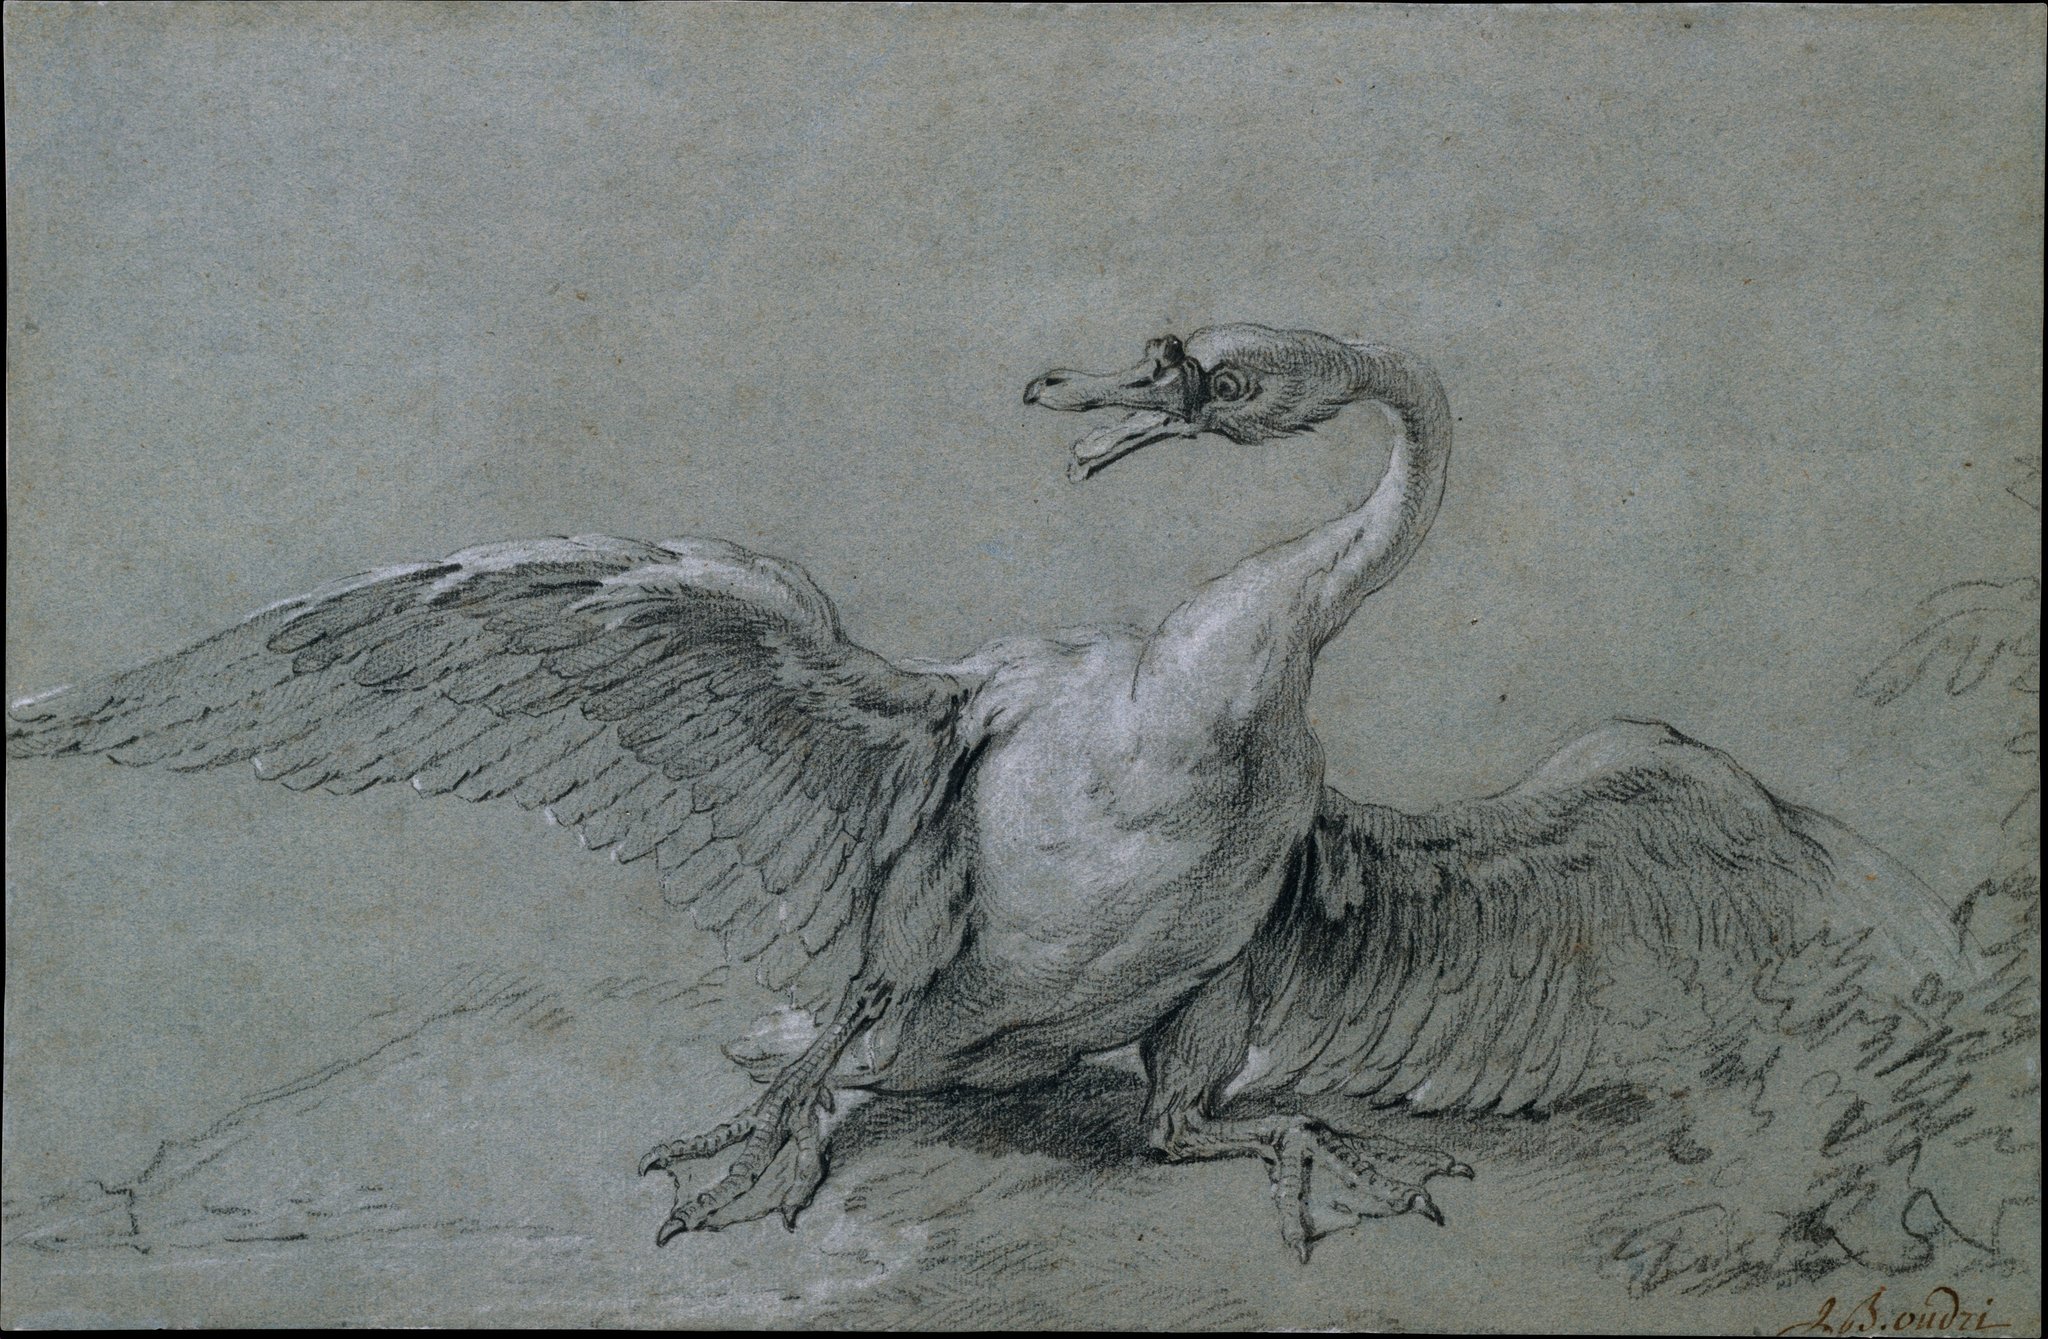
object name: drawing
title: Angry Swan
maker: jean-baptiste oudry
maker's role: artist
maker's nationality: french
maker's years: 1686-1755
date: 1701-1800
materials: chalk, paper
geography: france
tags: swans